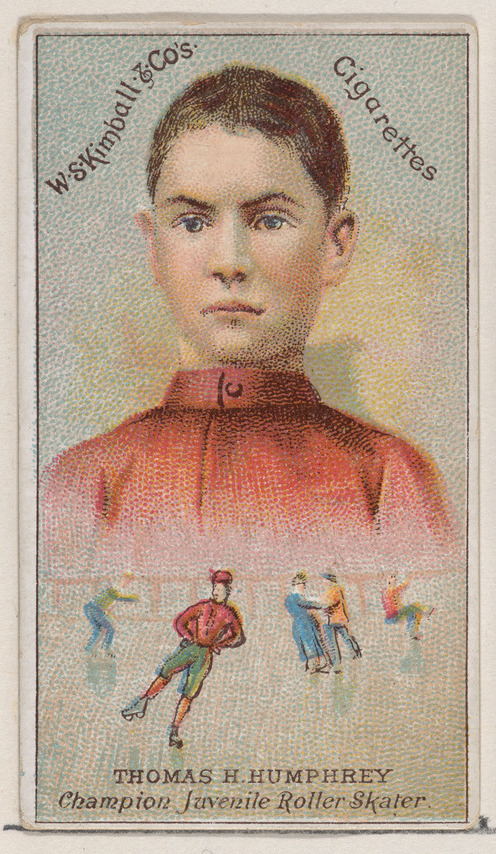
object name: print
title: Thomas H. Humphrey, Champion Juvenile Roller Skater, from the Champions of Games and Sports series (N184, Type 1) issued by W.S. Kimball & Co.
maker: w.s. kimball & co.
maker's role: publisher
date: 1887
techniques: color lithograph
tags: boys,sports,athletes